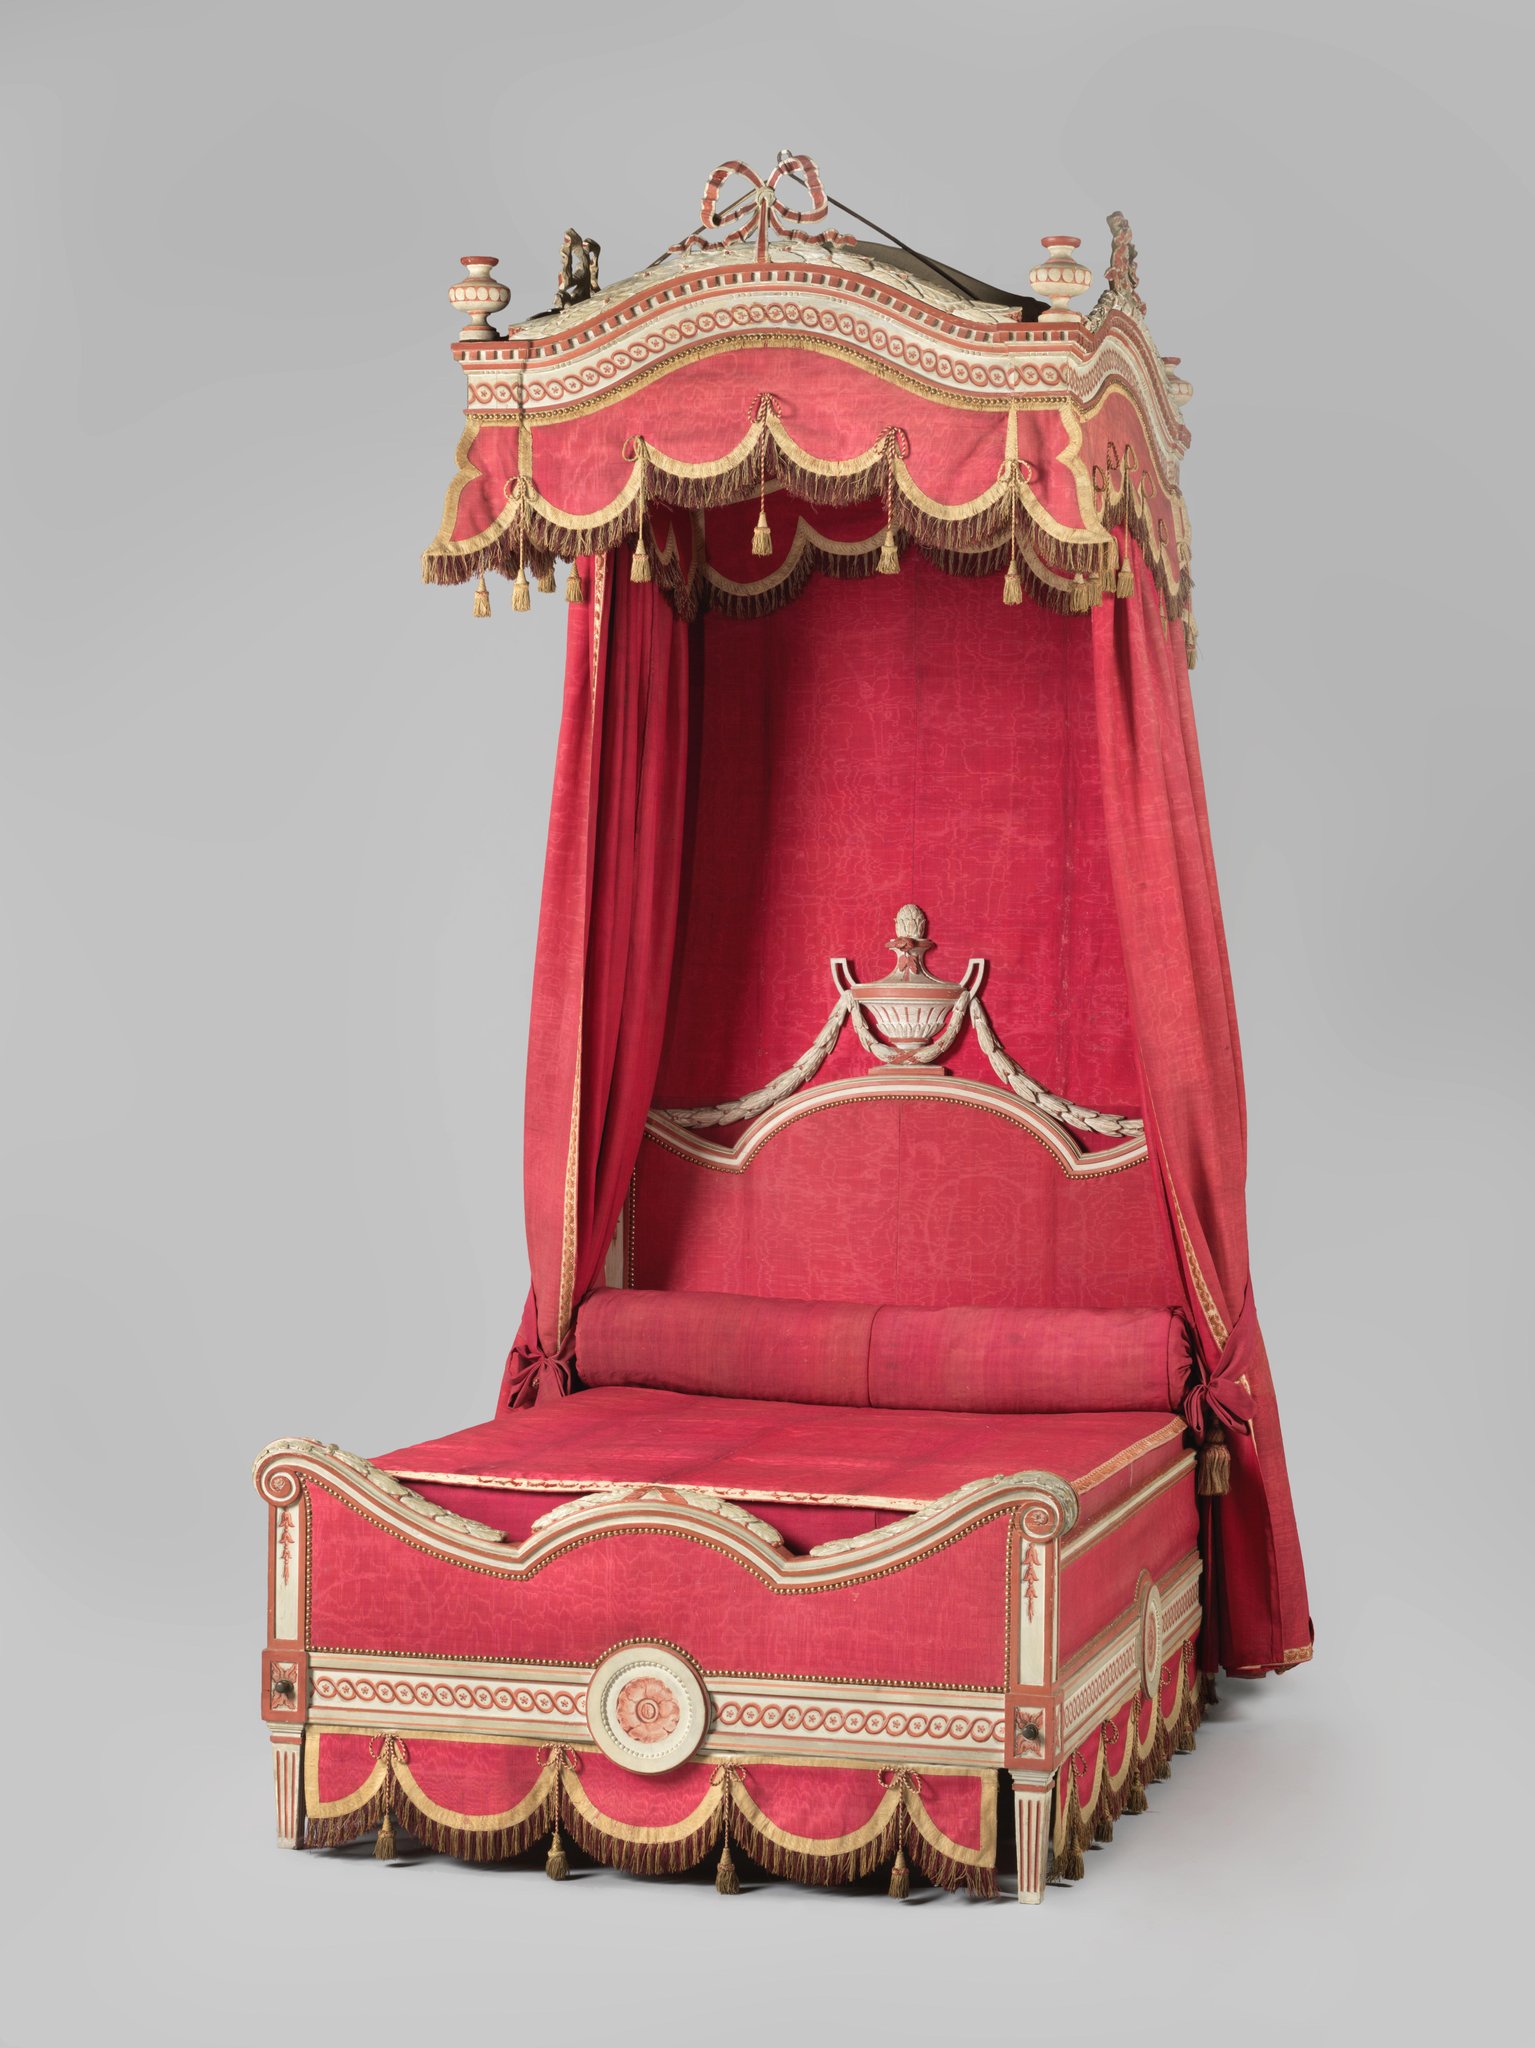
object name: bed curtain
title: Onderdelen behorend bij hemelbed behangen met rode wollen stof, met passementen en franjes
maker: Anonymous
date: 1775-1800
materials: cardboard, iron, wood, linen, paint, silk, wool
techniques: moire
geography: netherlands